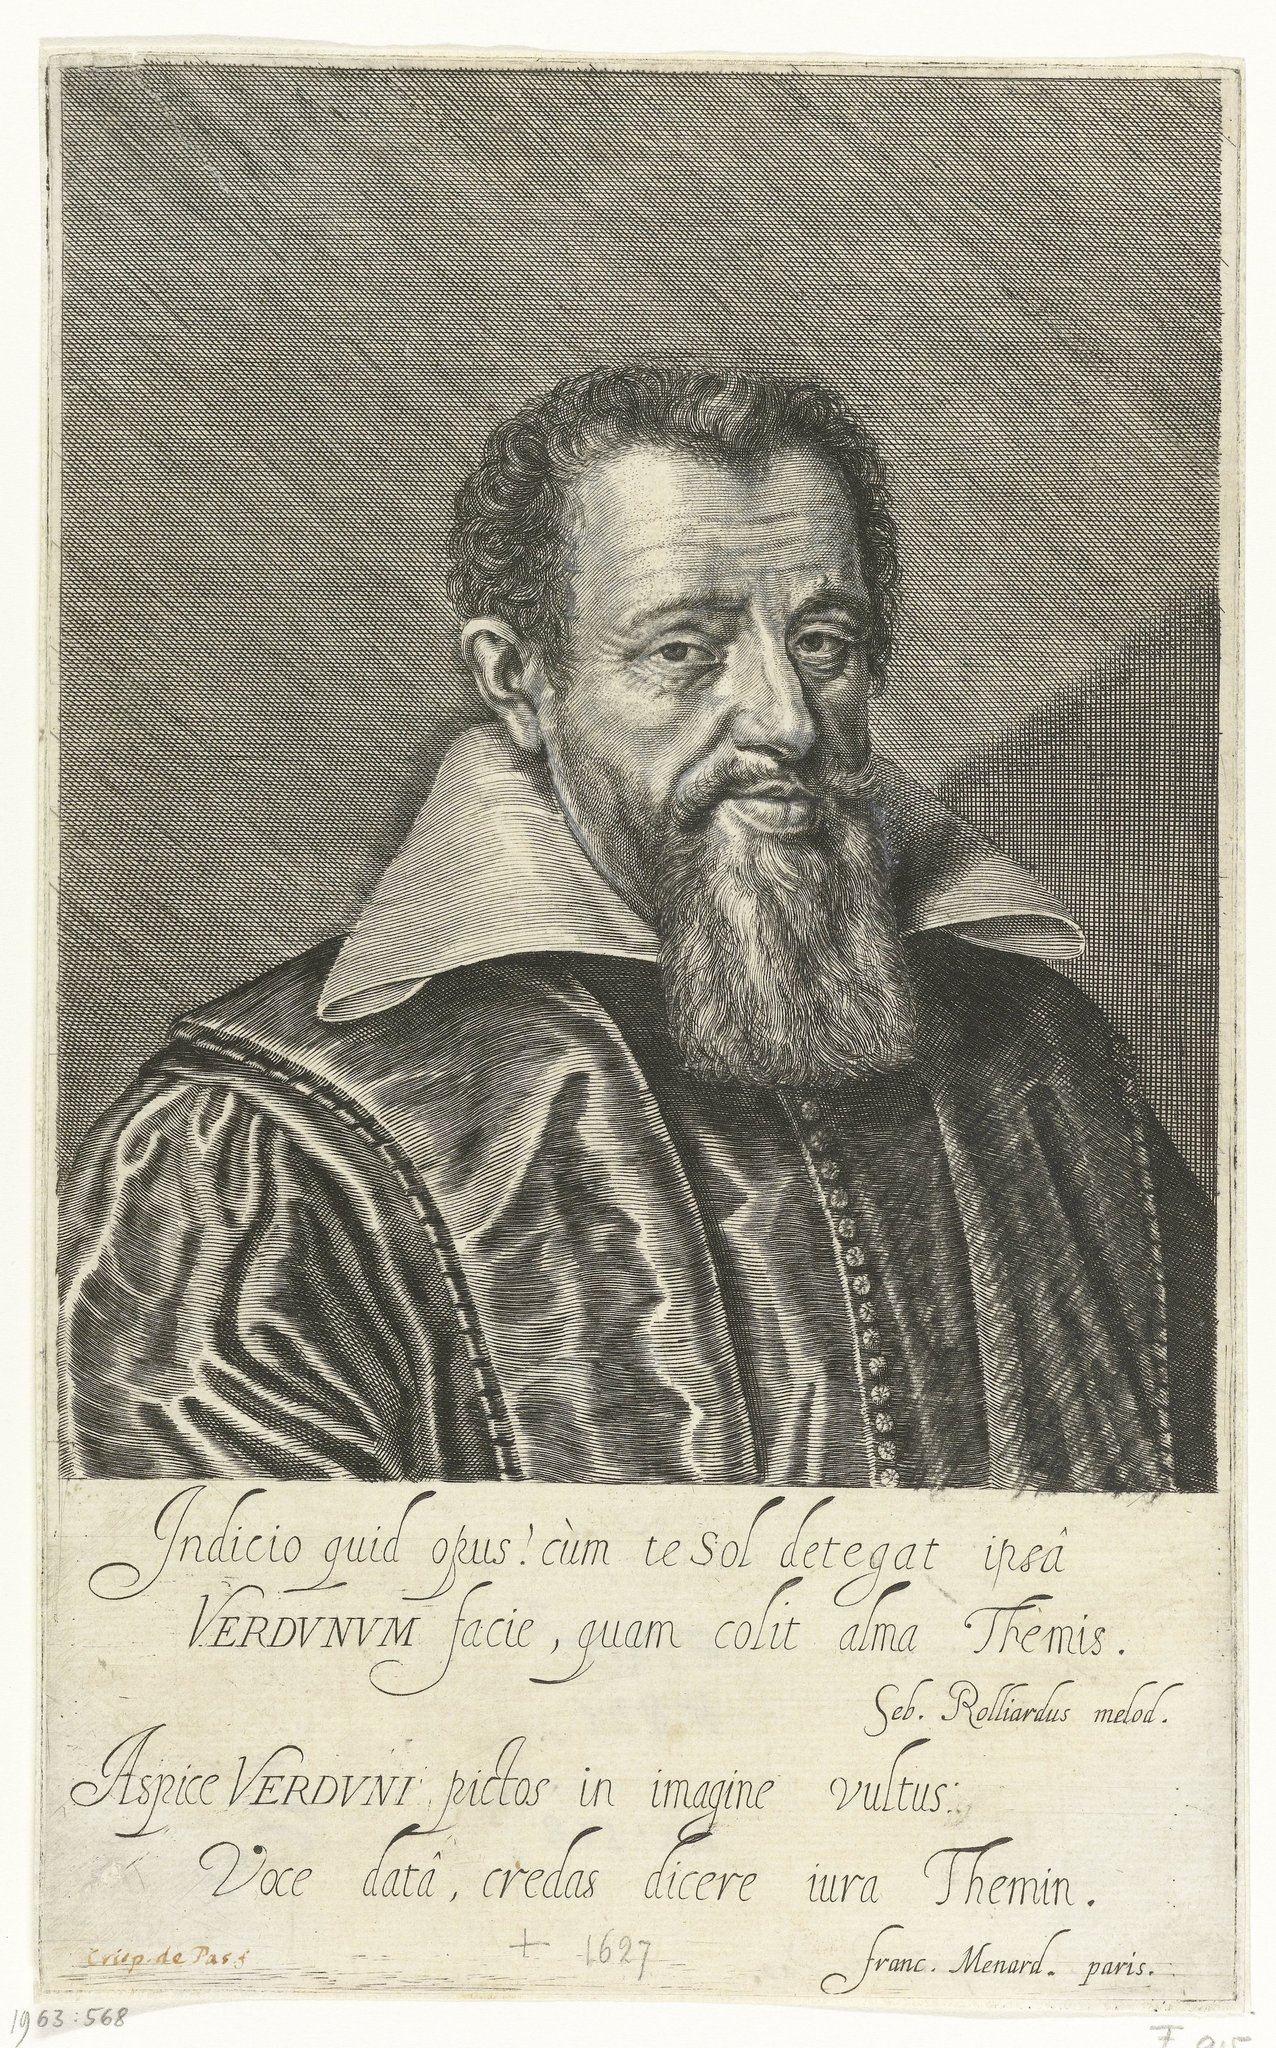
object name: print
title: Portret van Nicolas de Verdun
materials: paper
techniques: engraving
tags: coat: overcoat (+ men's clothes), neck-gear: collar (+ men's clothes), beard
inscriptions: inscription: ‘crisp de Pass’, inscription: ‘crispin de Pas’, collector's mark: Lugt 2228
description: Portret van Nicolas de Verdun, de eerste president van het Parijse parlement. Hij draagt een dubbelgevouwen kraag onder zijn tabbaard. In de marge twee gedichten in het Latijn.